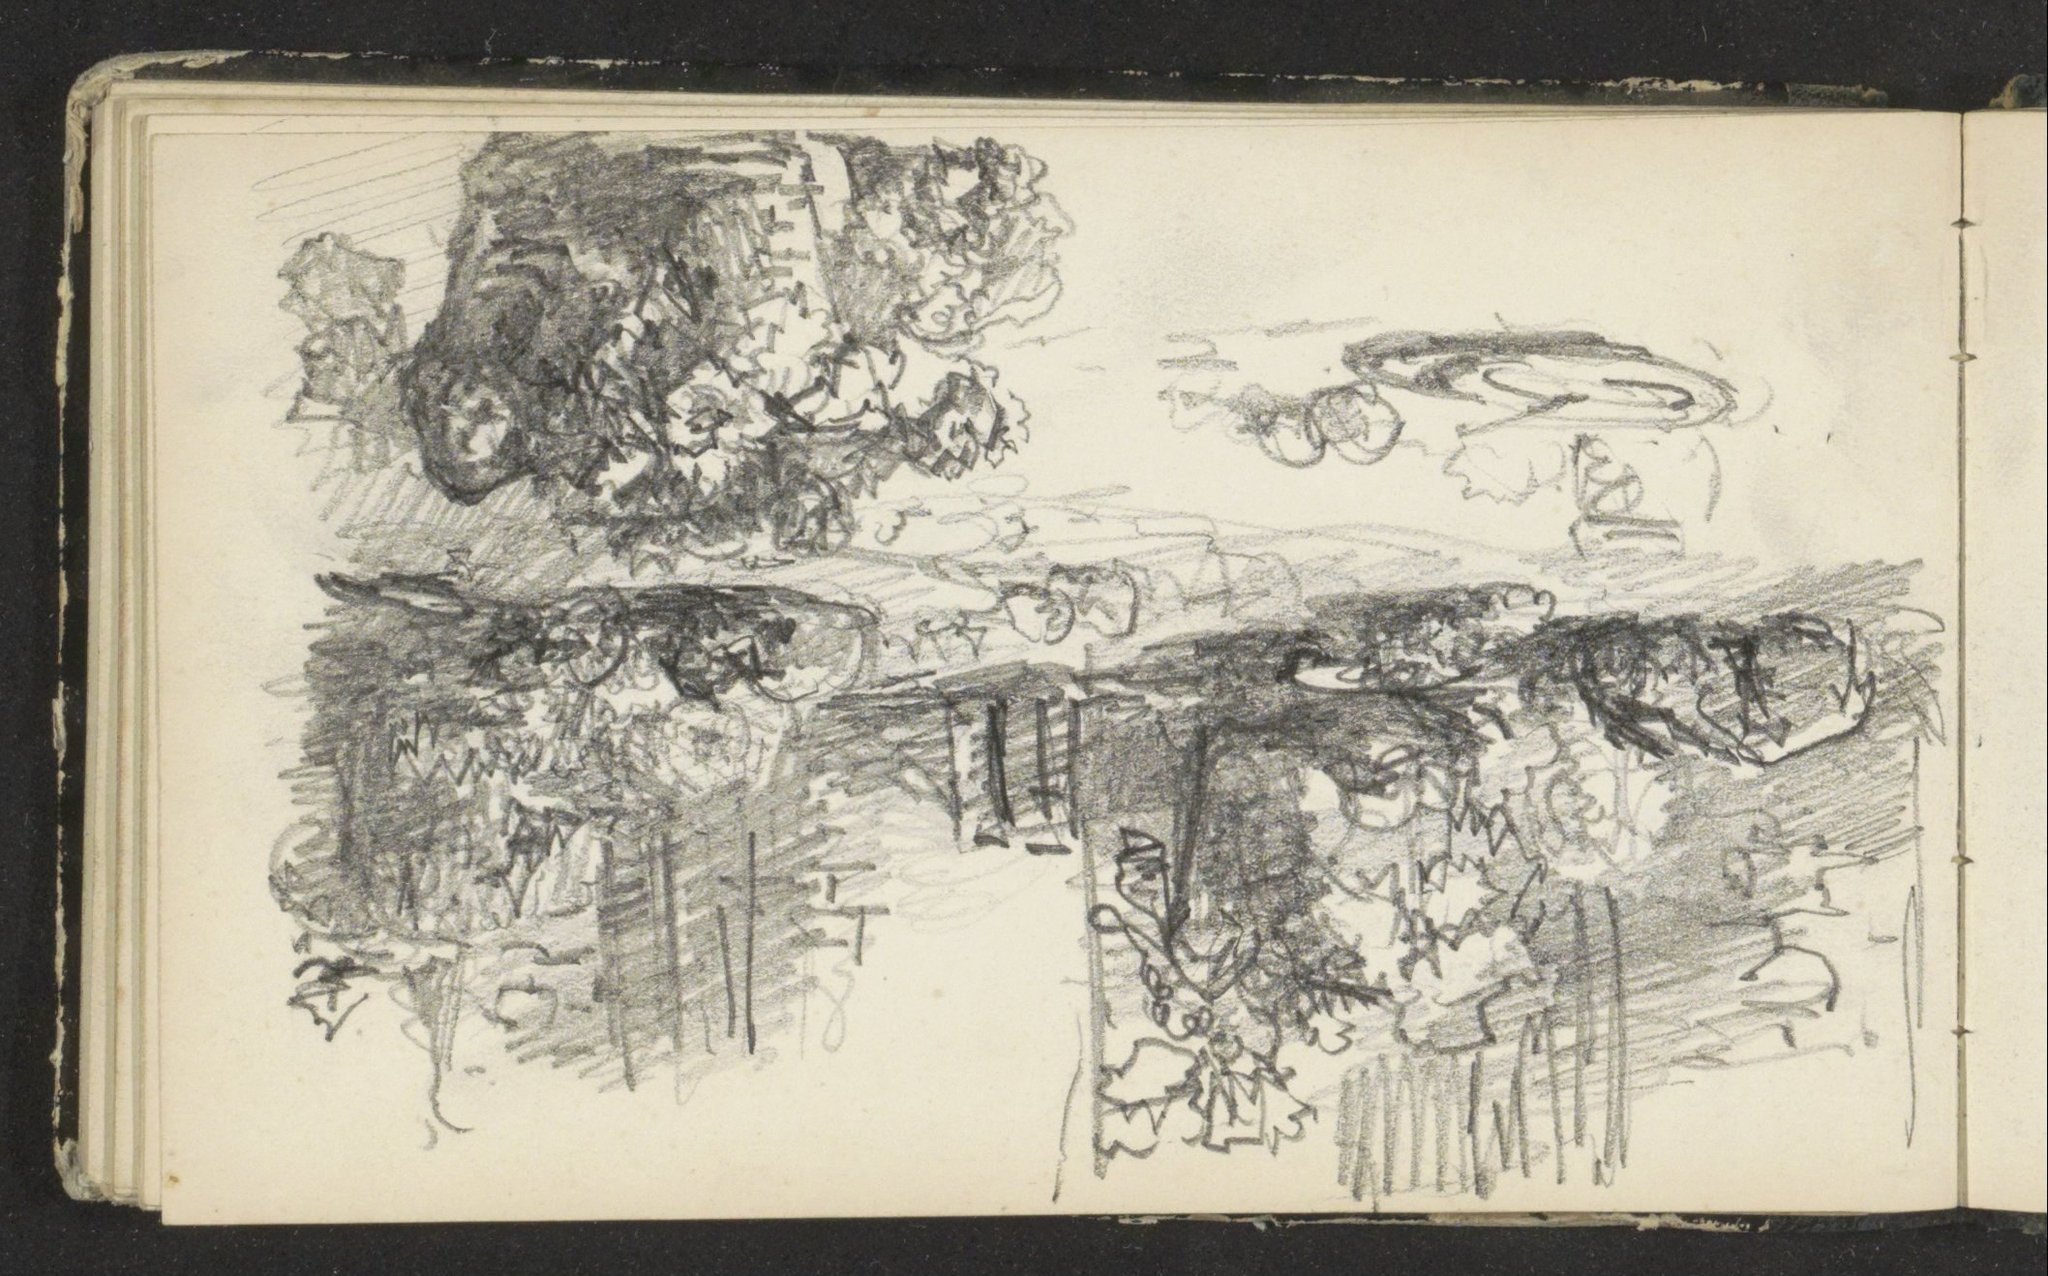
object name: sketchbook leaf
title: Landschap met struiken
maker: maria vos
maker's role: draughtsman, painter, print maker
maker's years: 1824-1906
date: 1834-1906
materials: paper, pencil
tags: landscapes, shrubs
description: Blad 29 verso uit een schetsboek met 46 bladen.